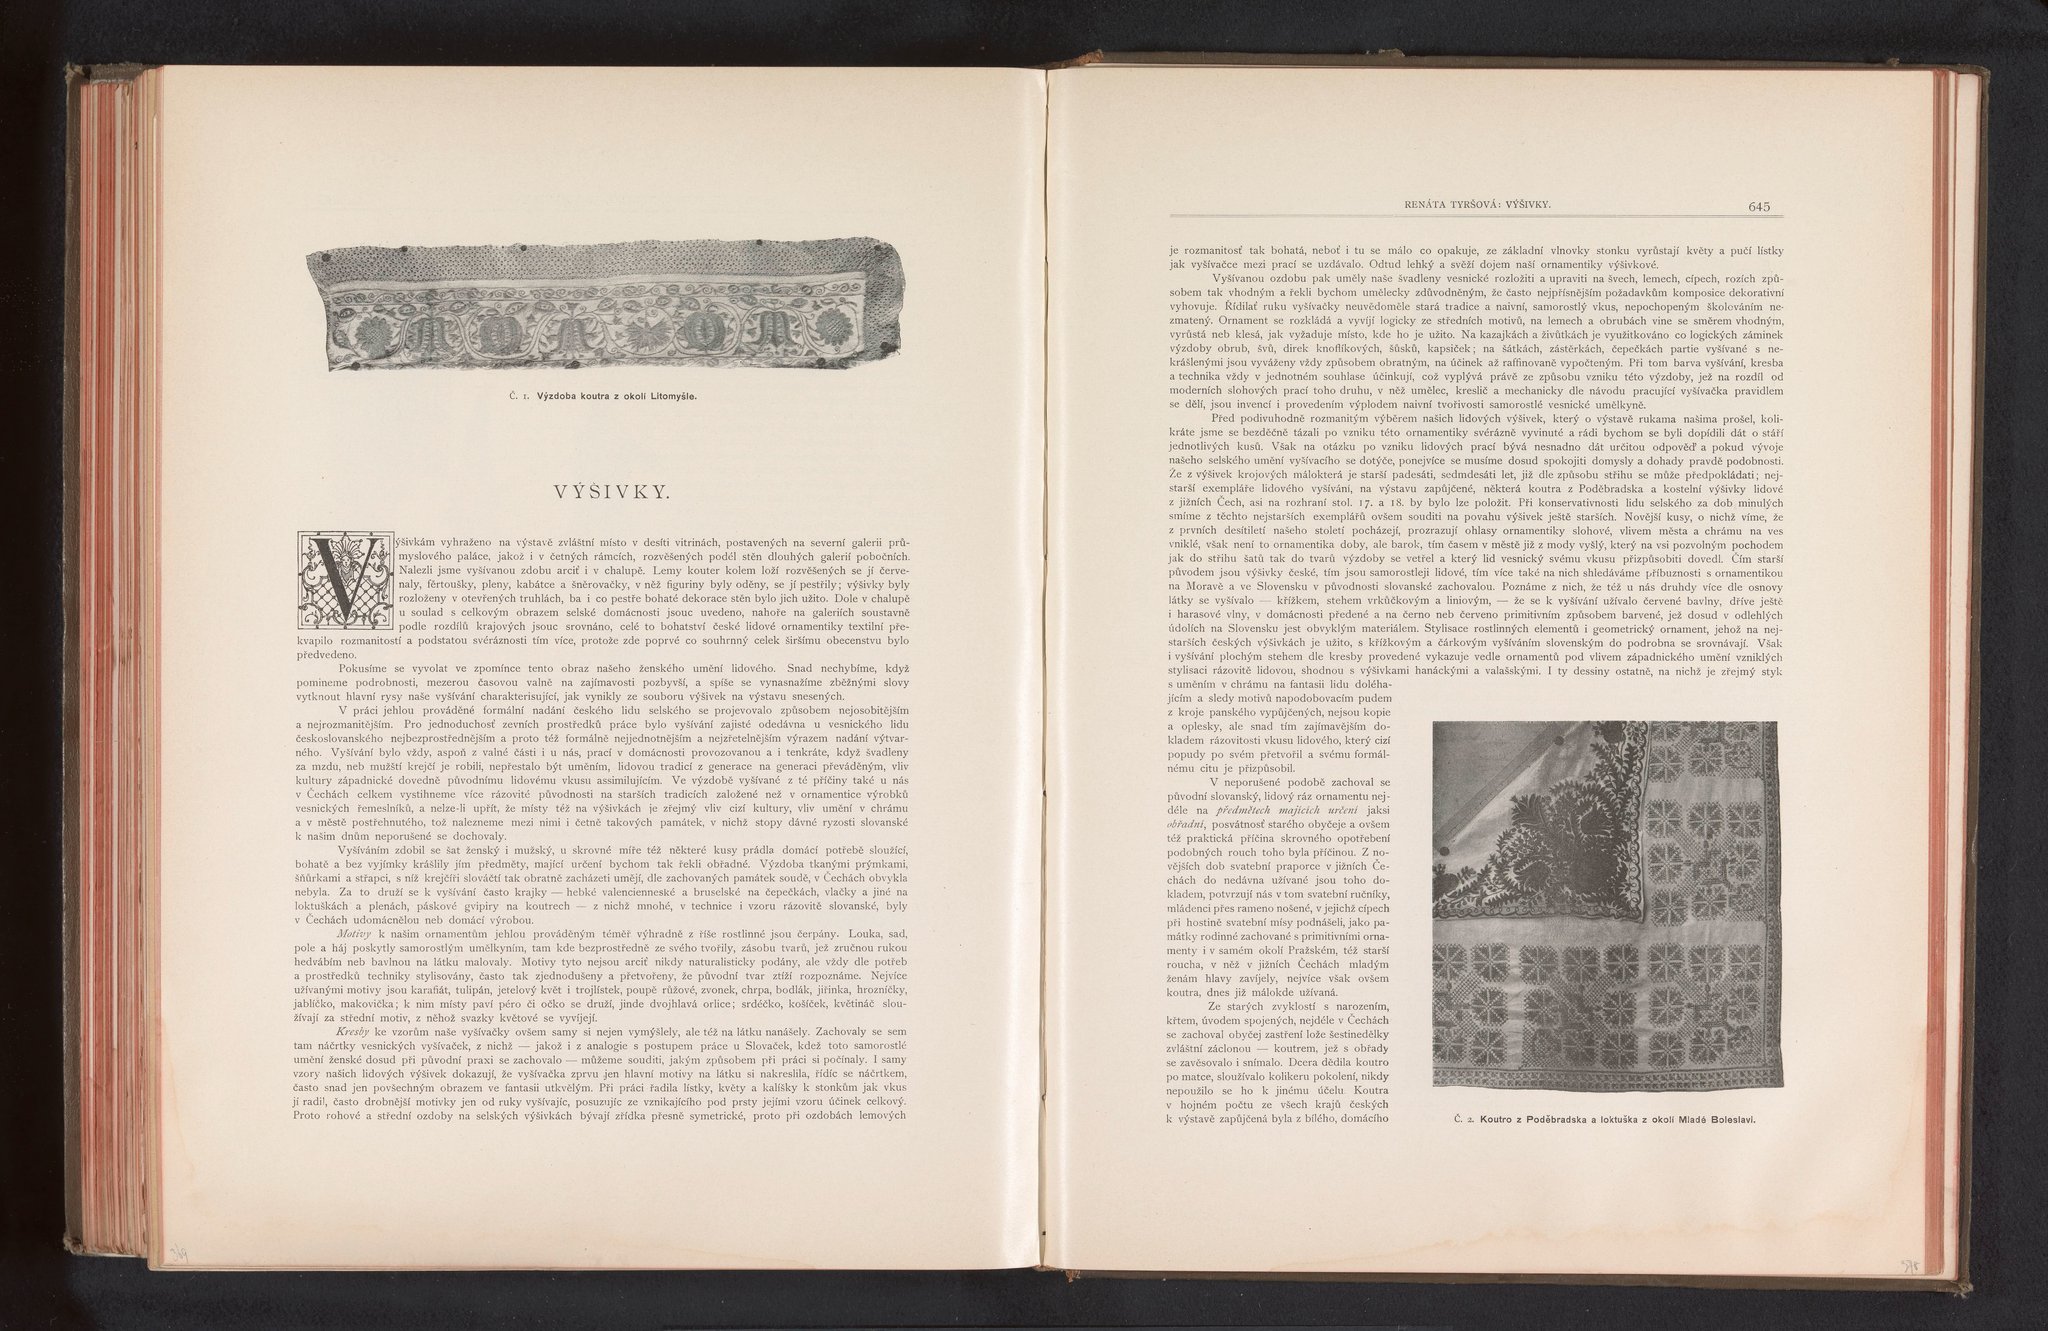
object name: page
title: Versiering uit de omgeving van Mladá Boleslav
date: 1891-1895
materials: paper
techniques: autotype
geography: prague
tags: flat decoration ~ applied arts